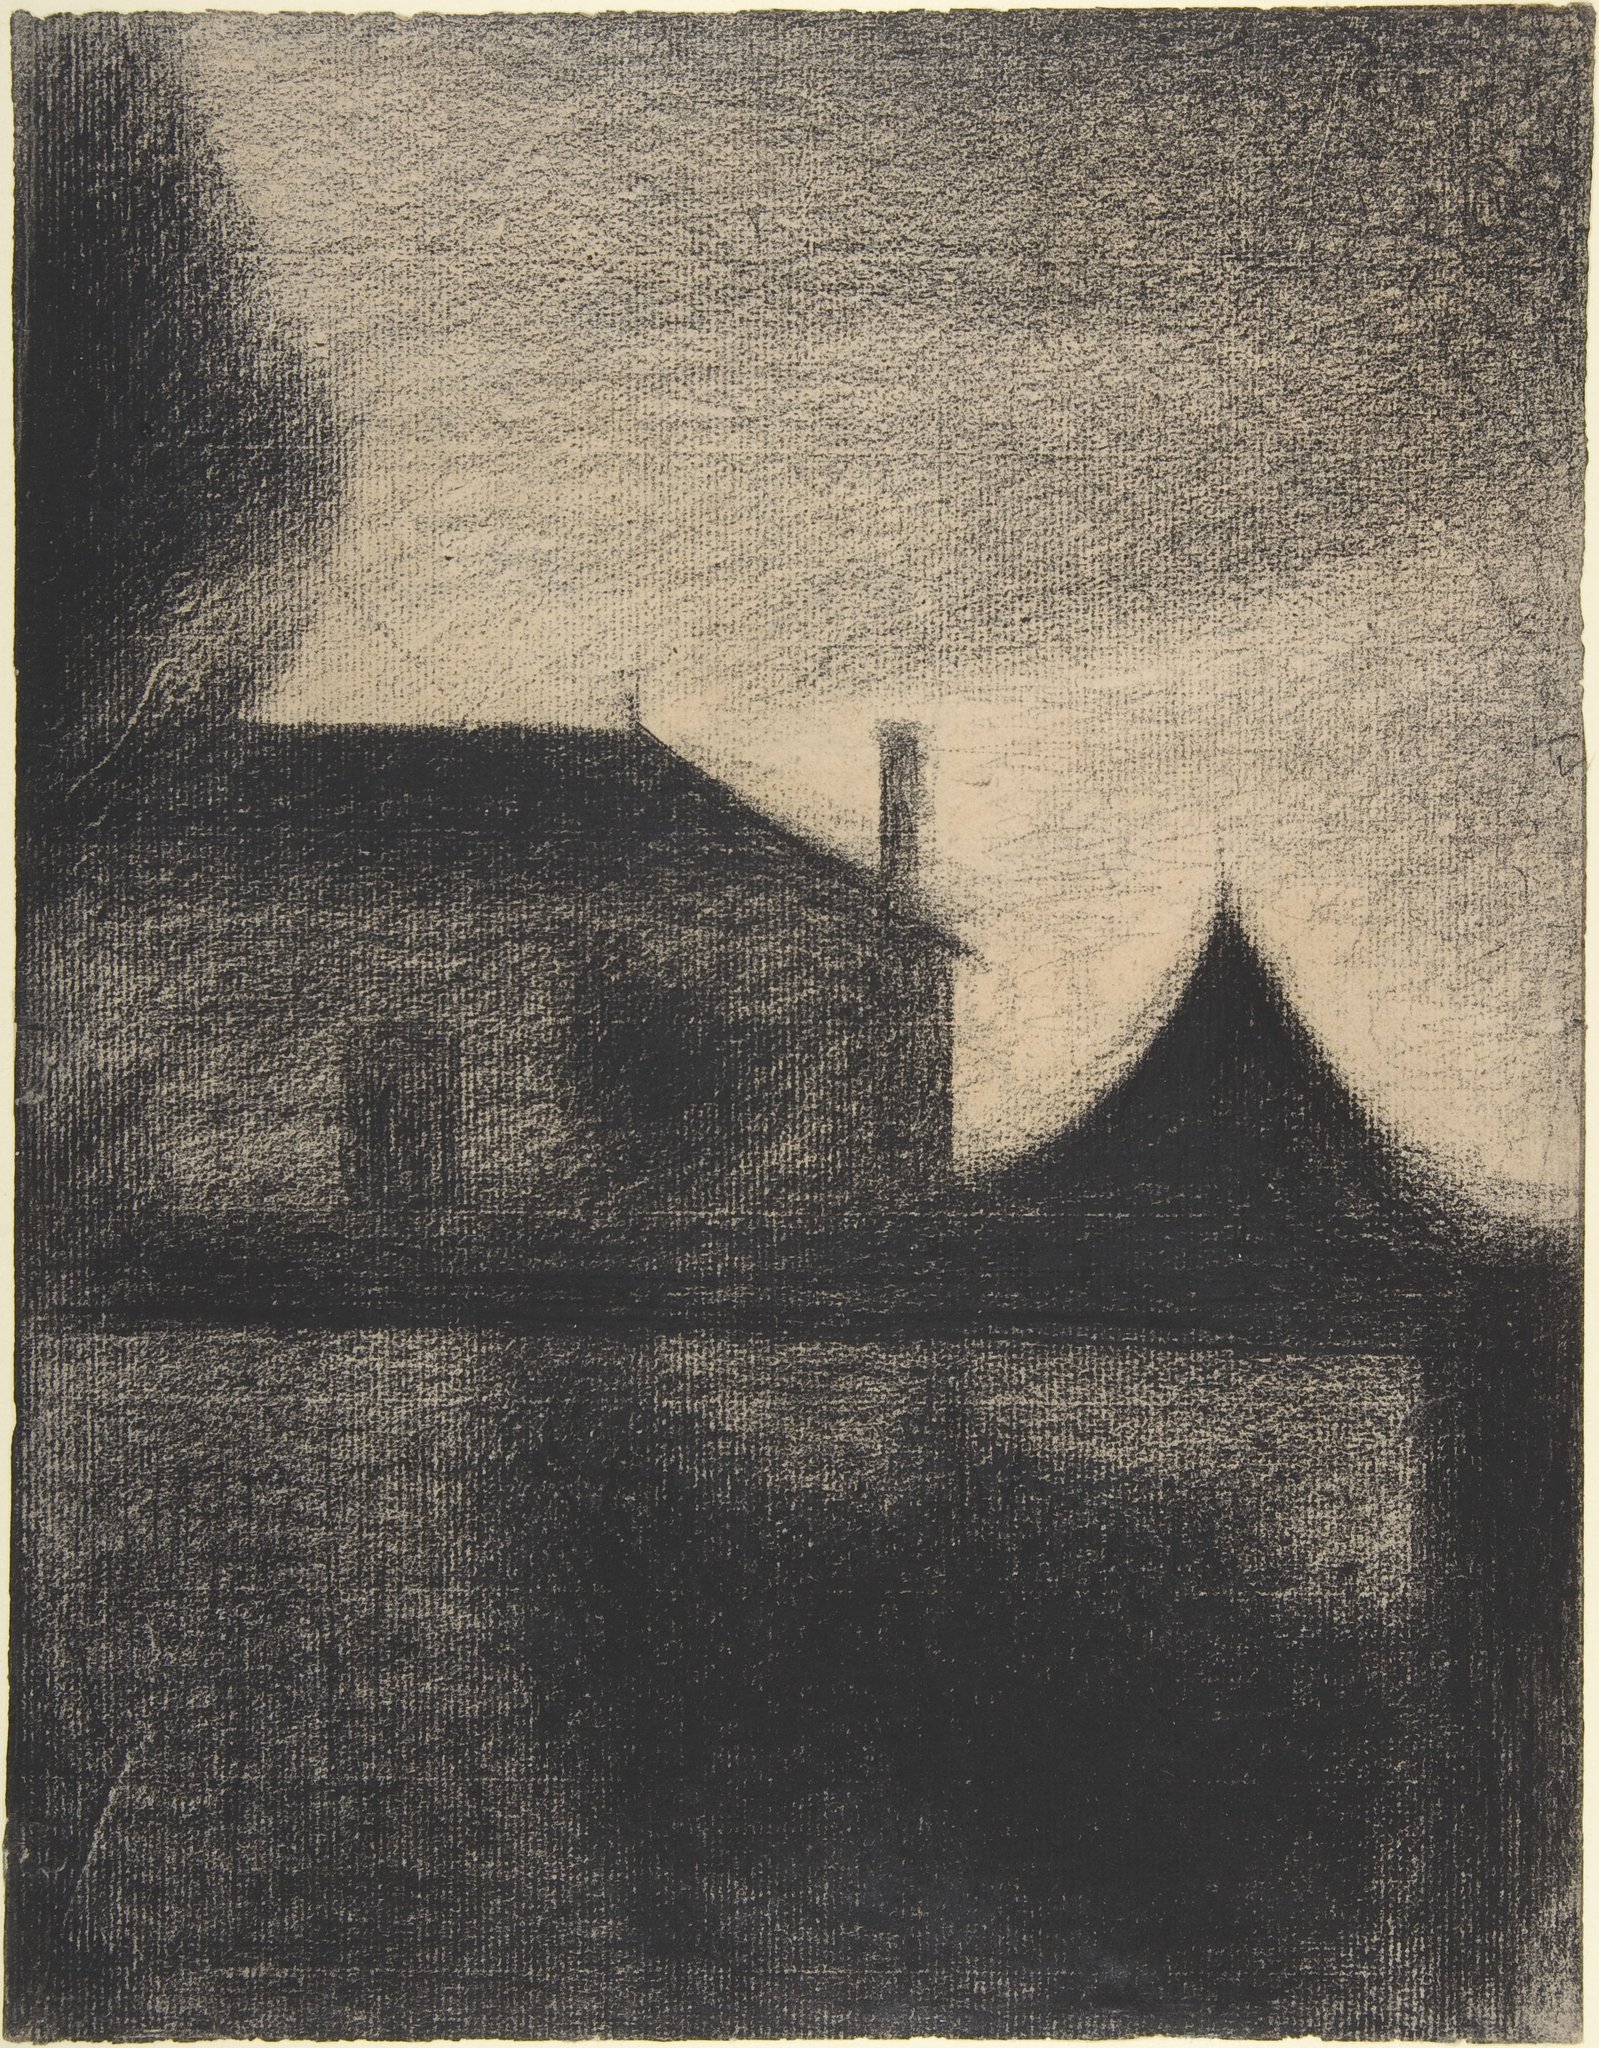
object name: drawing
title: House at Dusk (La Cité)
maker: georges seurat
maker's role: artist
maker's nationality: french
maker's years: 1859-1891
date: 1881-1882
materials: crayon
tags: houses,evening